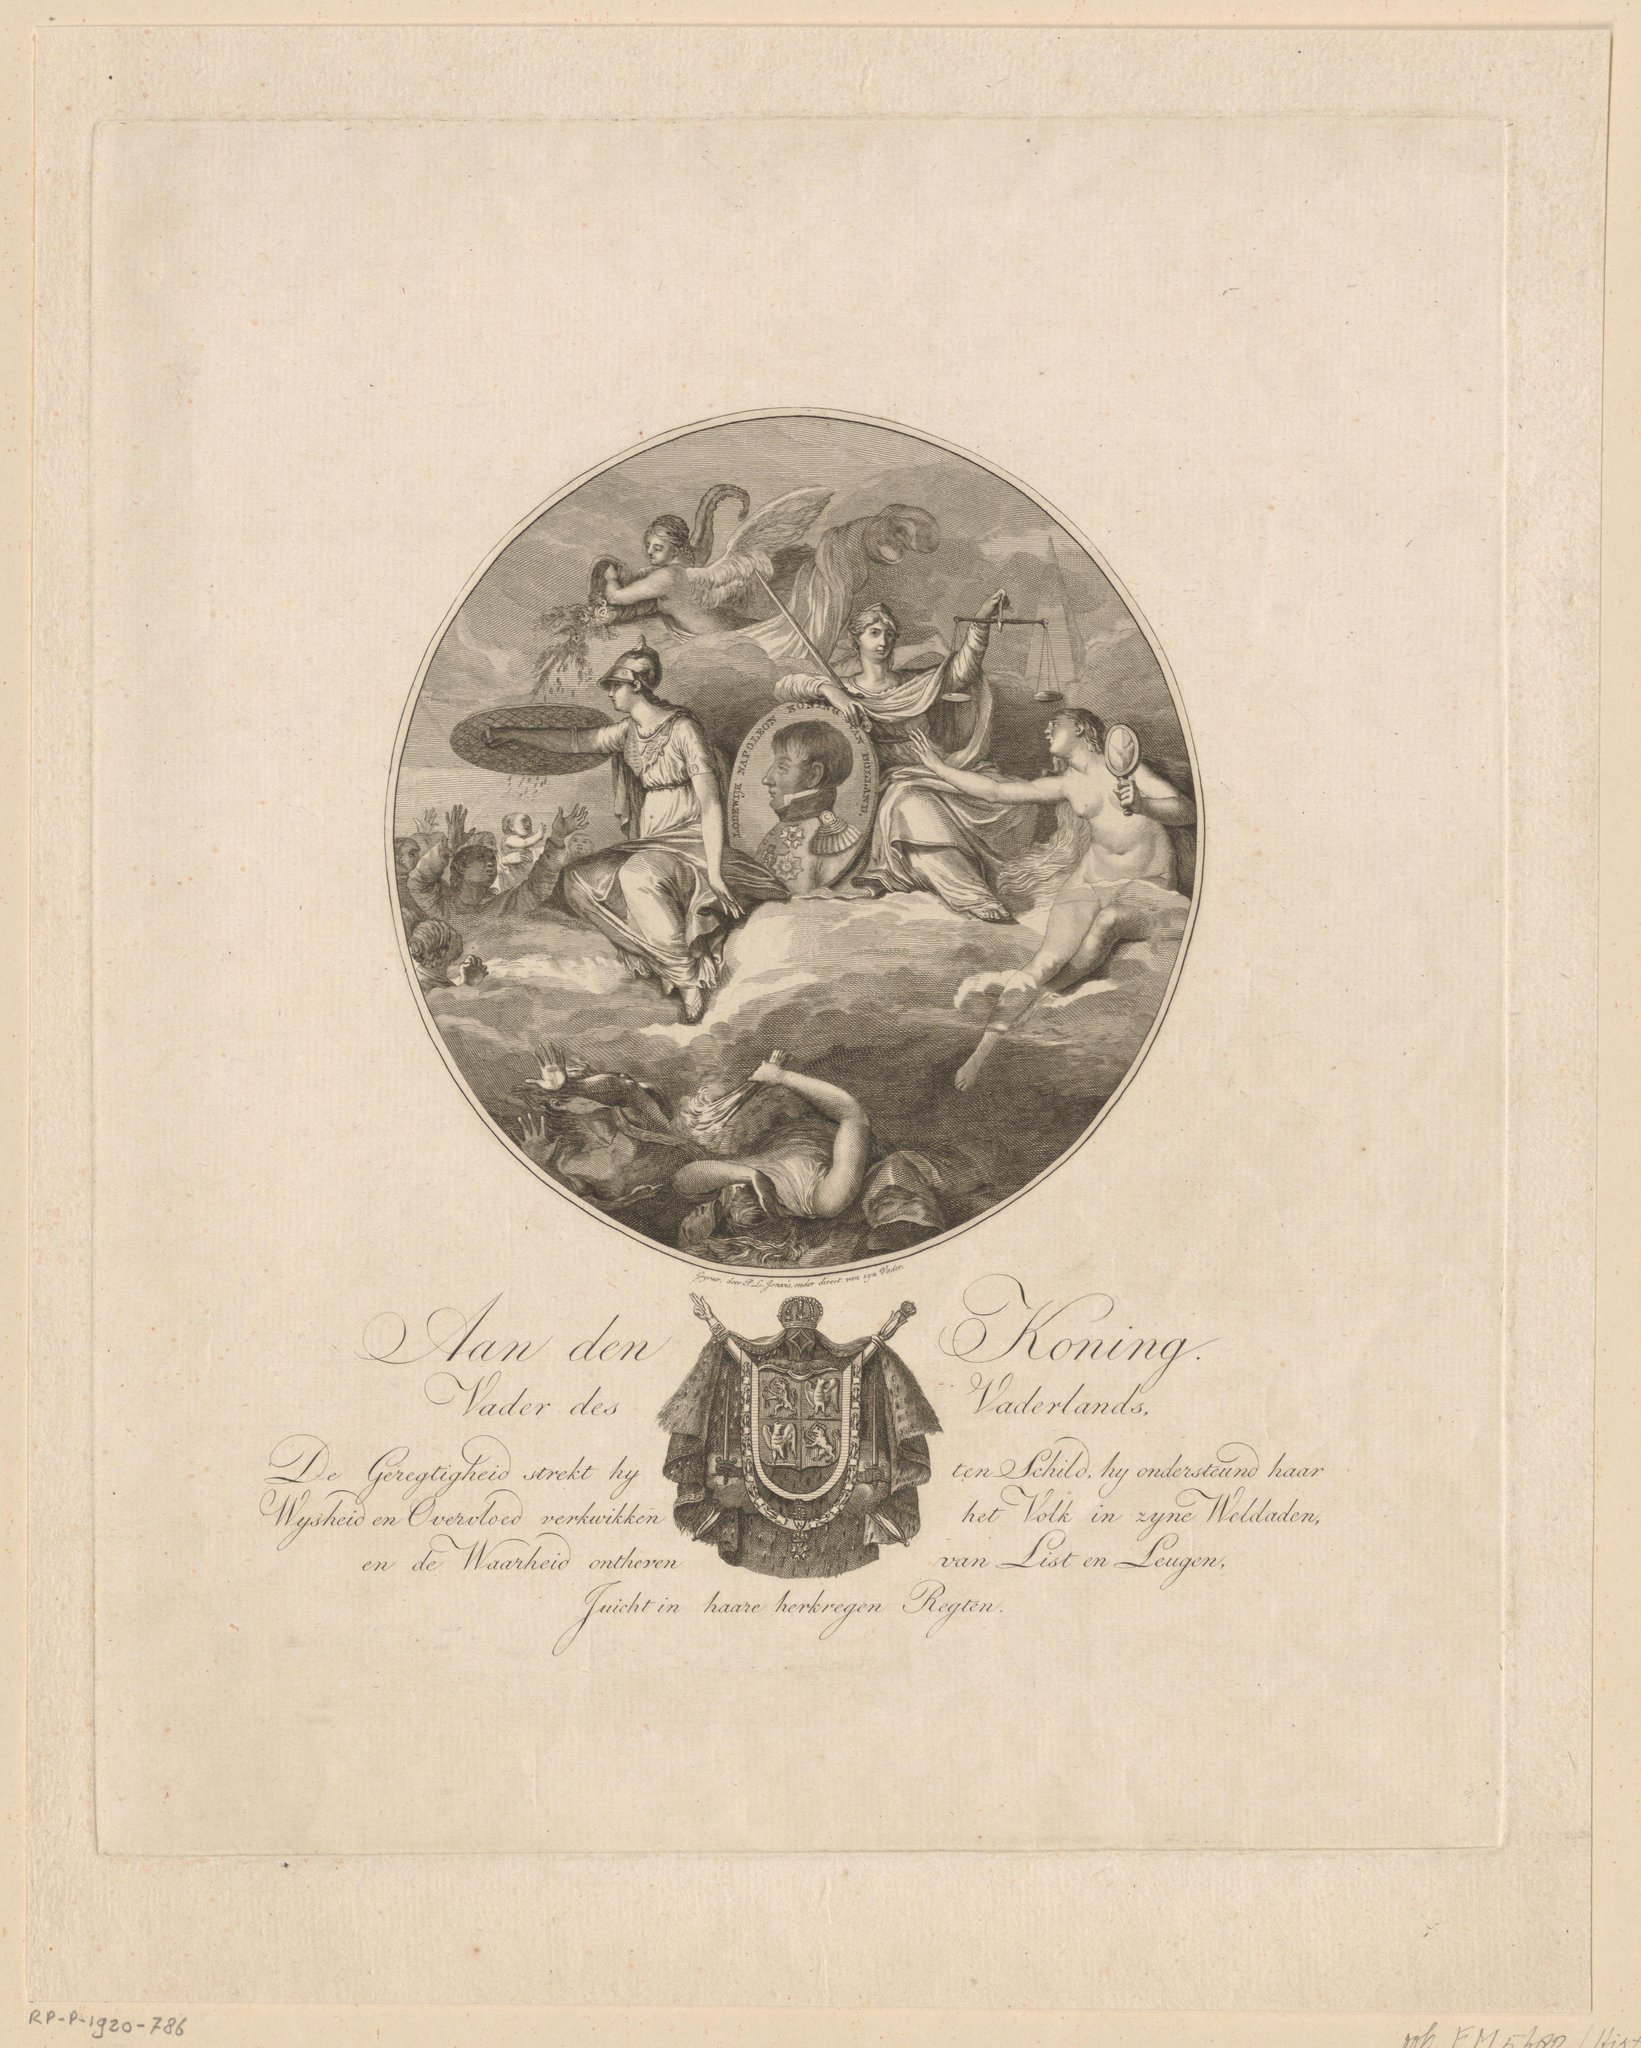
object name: print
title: Aan den Koning. Vader des Vaderlands, (...)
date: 1806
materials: paper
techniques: engraving, etching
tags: louis napoleon (king of holland), wisdom; 'sapienza', 'sapienza humana', 'sapienza vera' (ripa), historical persons, abundance; 'abondanza', 'abondanza maritima' (ripa), truth; 'verità' (ripa), ruler, sovereign, justice, 'justitia'; 'giustitia divina' (ripa) ~ one of the four cardinal virtues - mm - triumph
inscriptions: collector's mark: Lugt 2228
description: Allegorische voorstelling met een portret van Lodewijk Napoleon, waarschijnlijk naar aanleiding van zijn komst naar Nederland, juni 1806. Zijn portret wordt omringd door de Wijsheid, gepersonifieerd door Minerva in wapenrusting en de Overvloed, met een hoorn des overvloeds, die voedsel strooien naar de mensen. Gerechtigheid, met weegschaal, en de Waarheid, met spiegel, die de List en Leugen verdrijven. Het geheel is gevat in een ovale omlijsting. In de marge het wapen van het Koninkrijk Holland en een zesregelig onderschrift in het Nederlands.